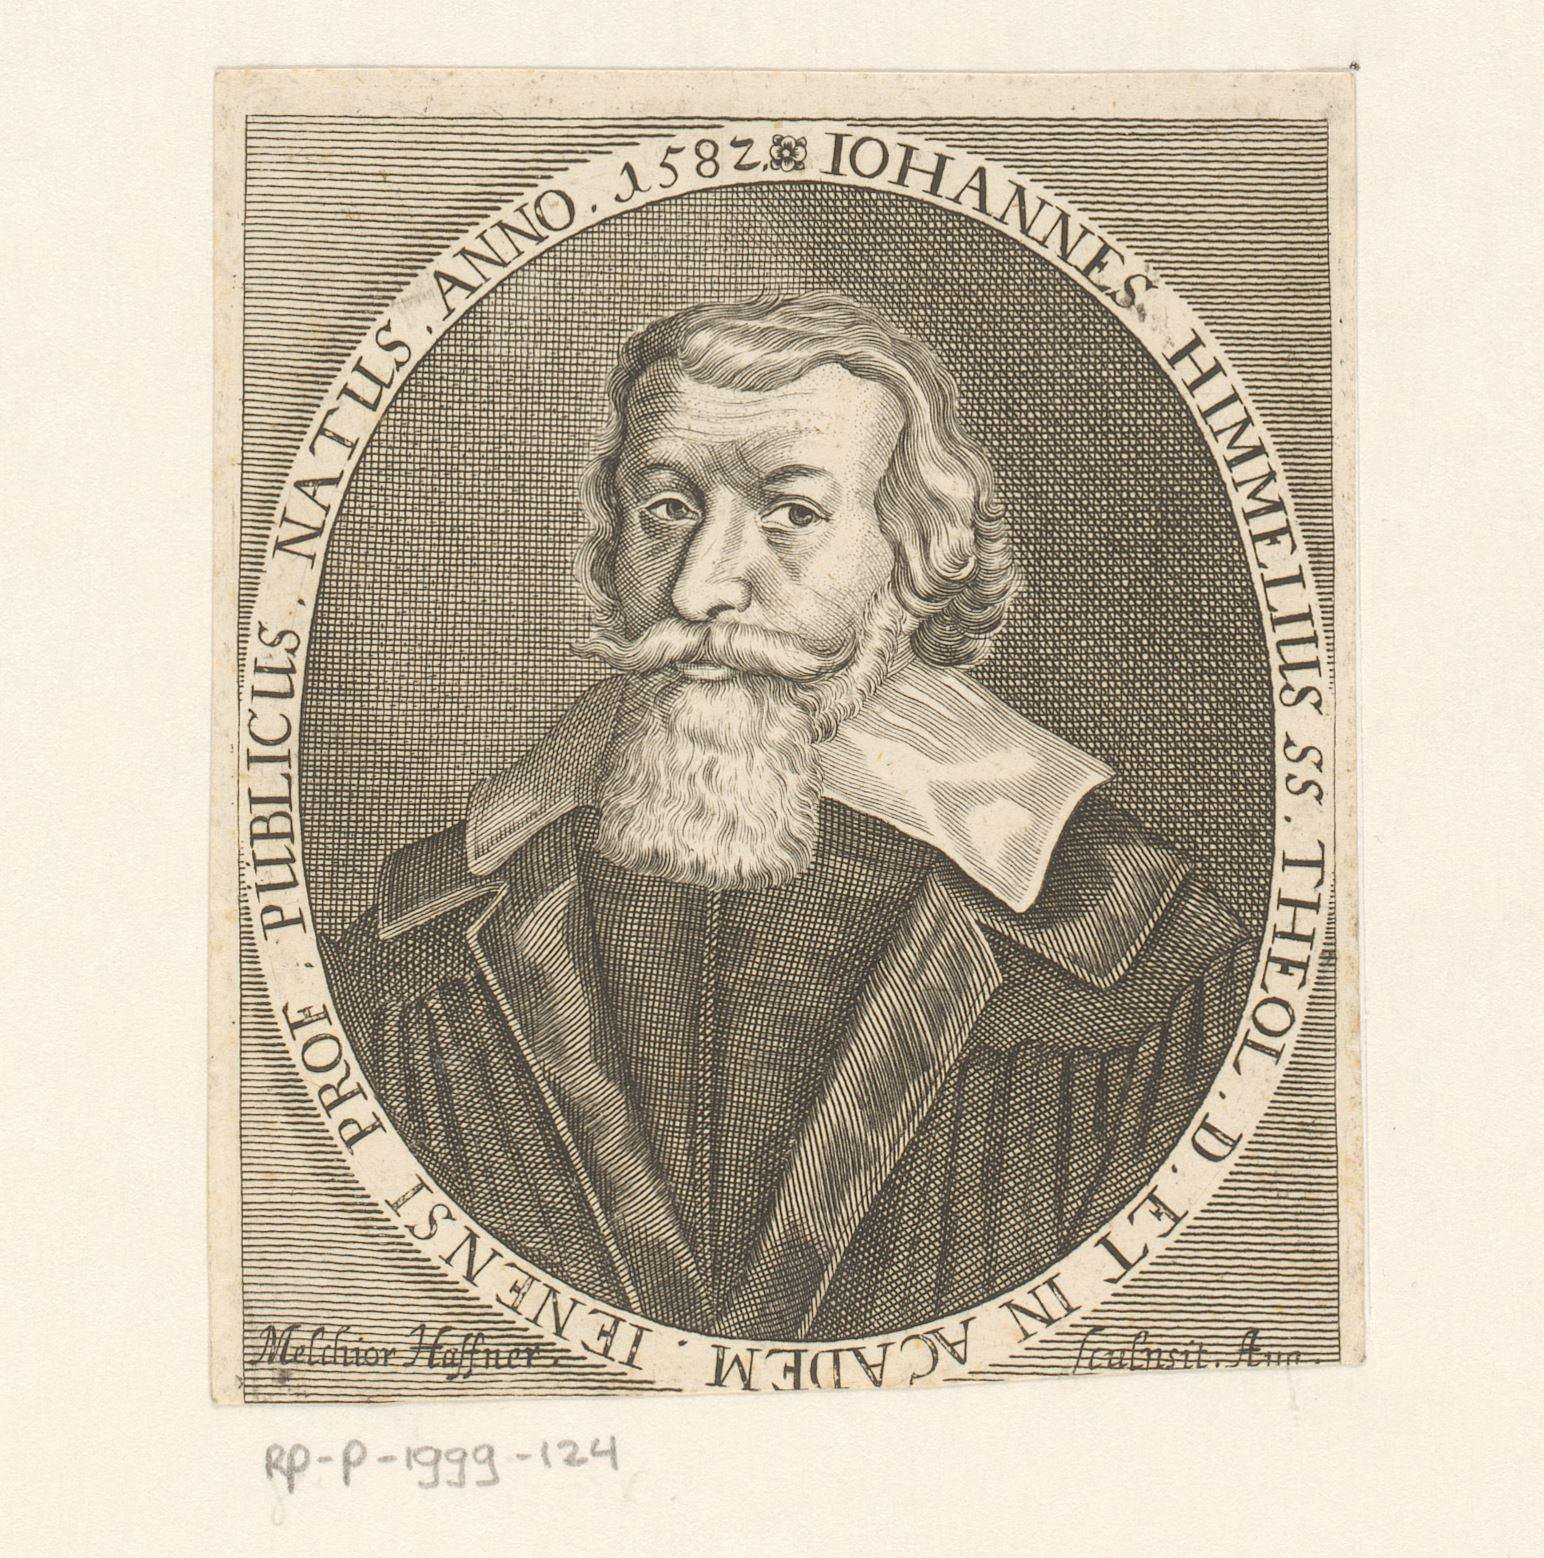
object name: book illustration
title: Iohannes Himmelius (...)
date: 1673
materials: paper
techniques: engraving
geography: augsburg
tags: theologian, historical persons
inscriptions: collector's mark: Lugt 2760, collector's mark: Lugt 2228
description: Prent ook gebruikt in: Spizel, Gottlieb. Templum honoris reseratum (...). Augsburg: Gottlieb Göbel, 1673.